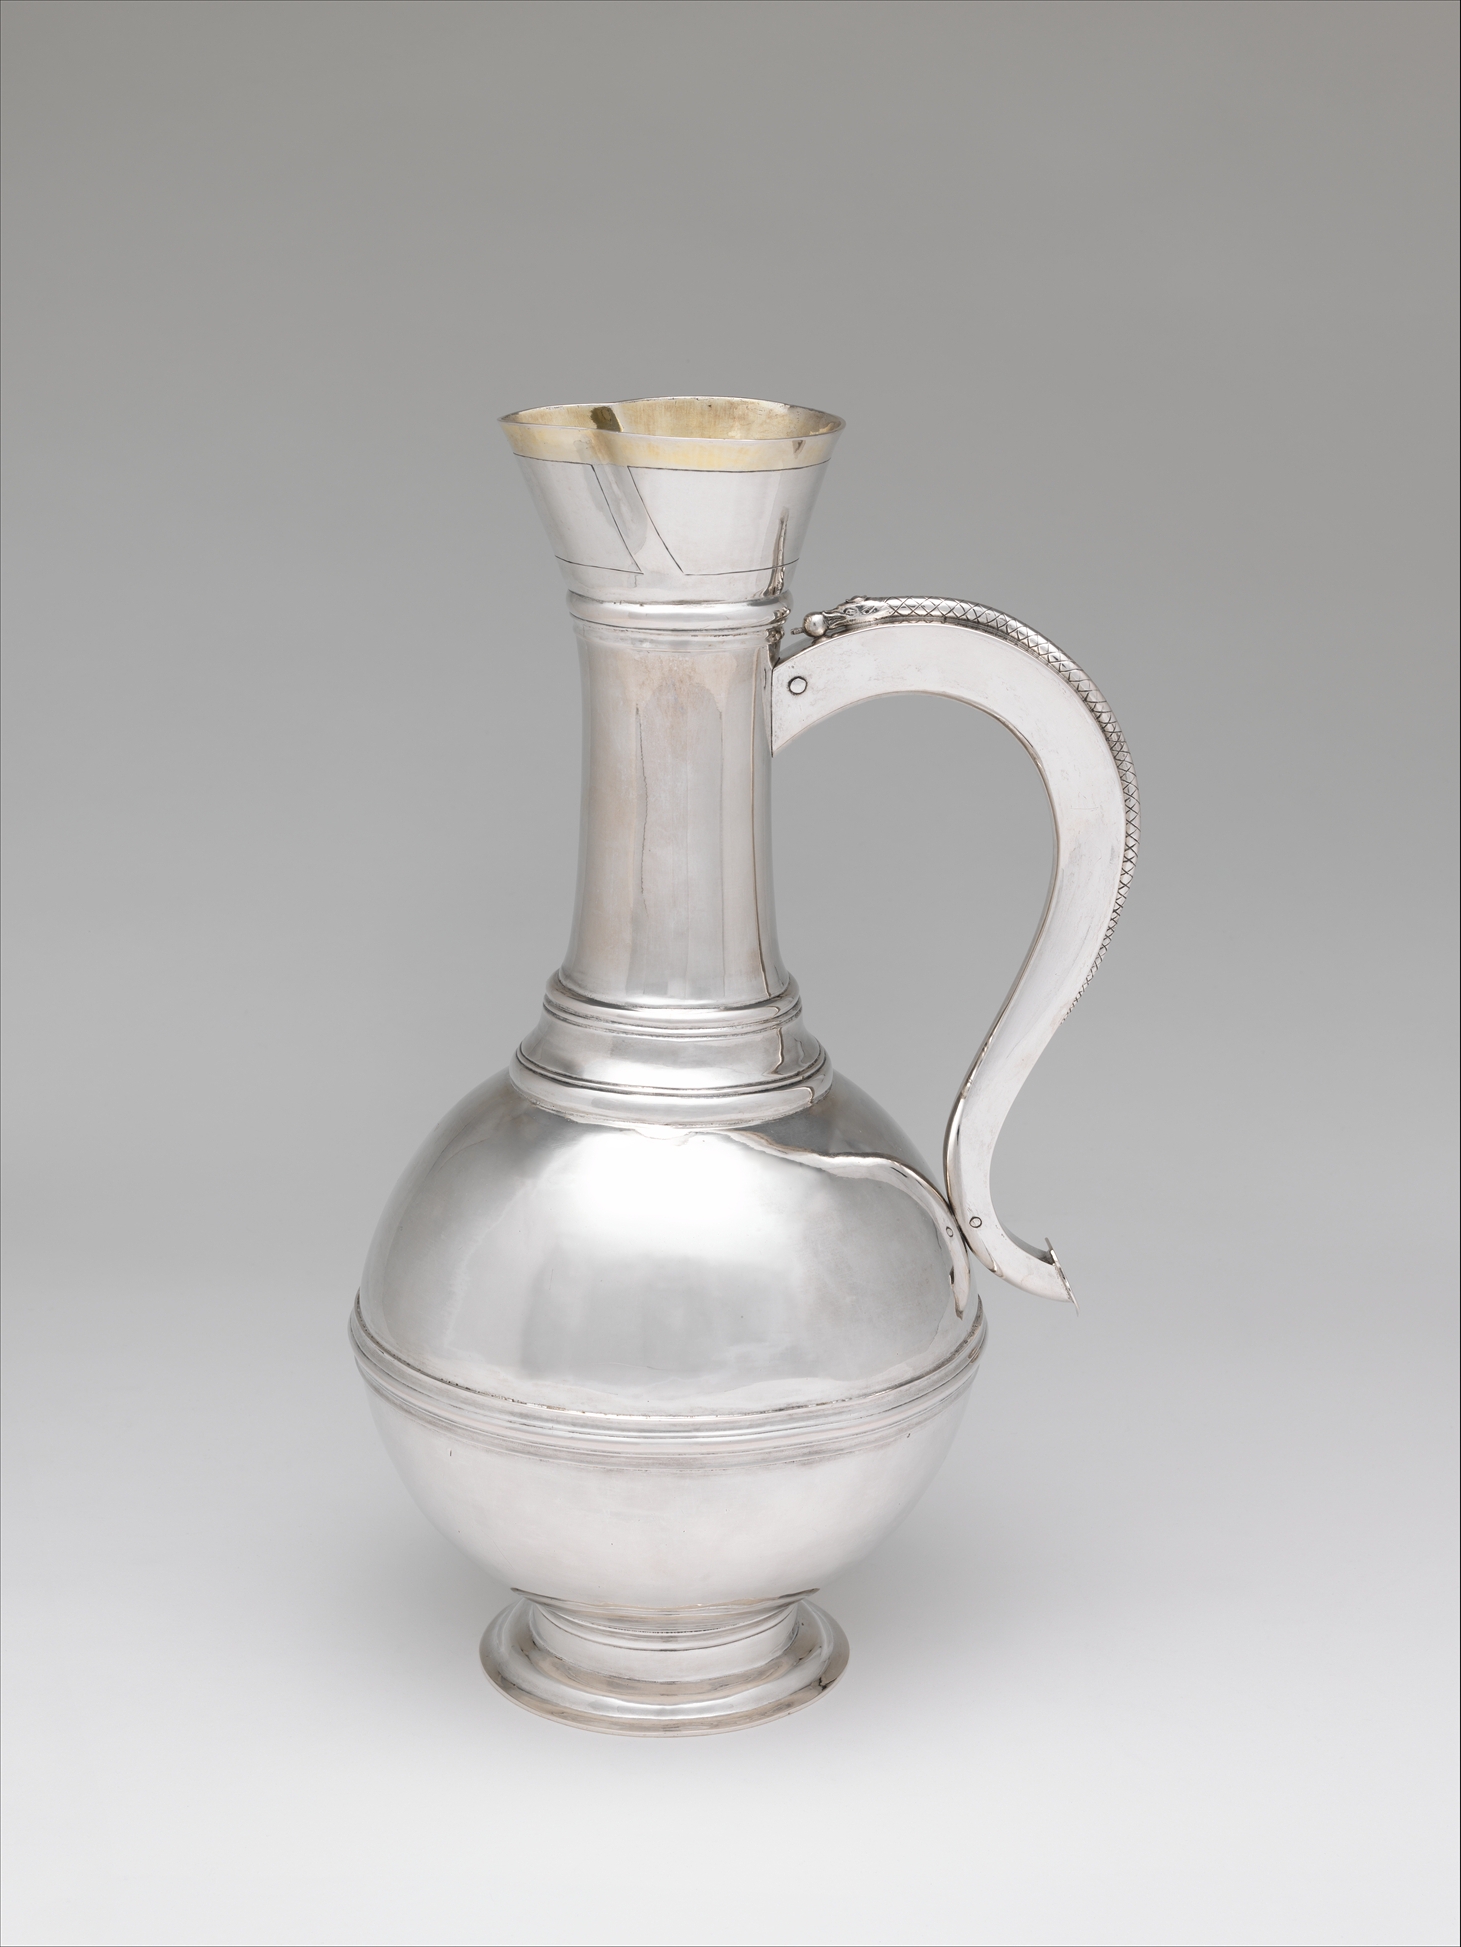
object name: wine decanter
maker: simon petrus conrad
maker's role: maker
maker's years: 1771-1793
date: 1780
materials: silver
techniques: gilding